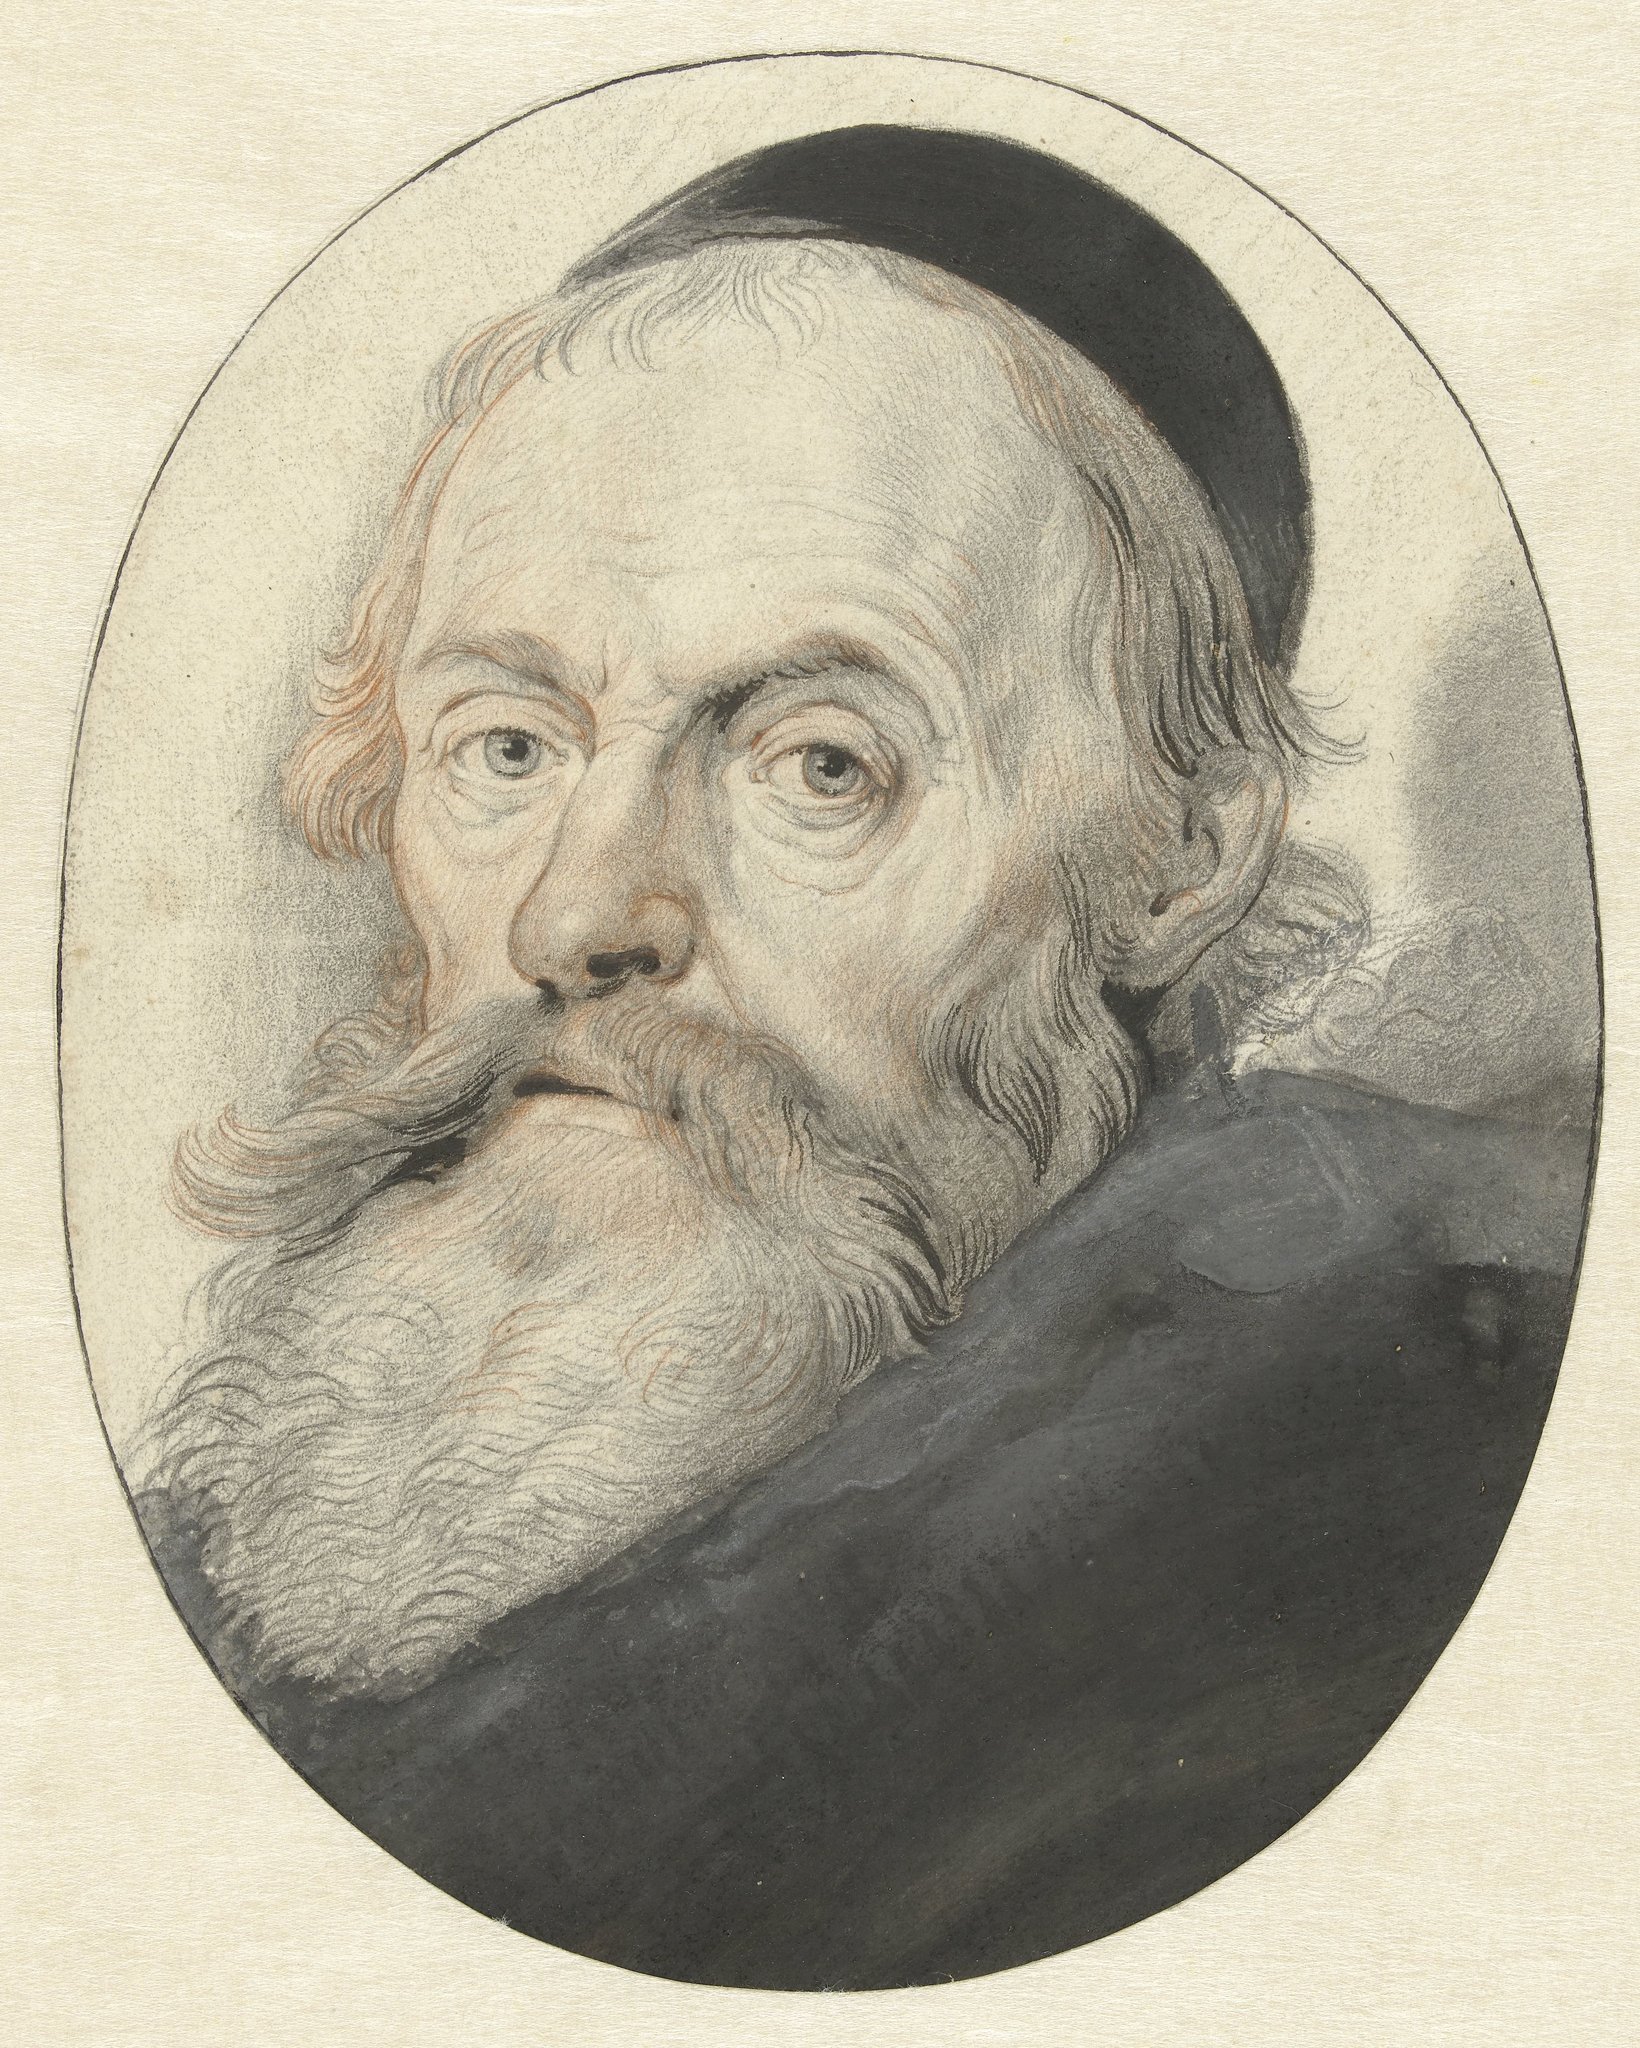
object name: drawing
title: Portret van Hendrick Goltzius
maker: pieter claesz. soutman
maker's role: draughtsman, print maker, publisher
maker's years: 1593-1657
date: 1644-1649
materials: chalk, paper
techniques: brush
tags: haarlem, print maker, draughtsman, hendrick goltzius, historical persons, portrait, self-portrait of painter, portrait, self-portrait of artist, portrait, self-portrait of graphic artist